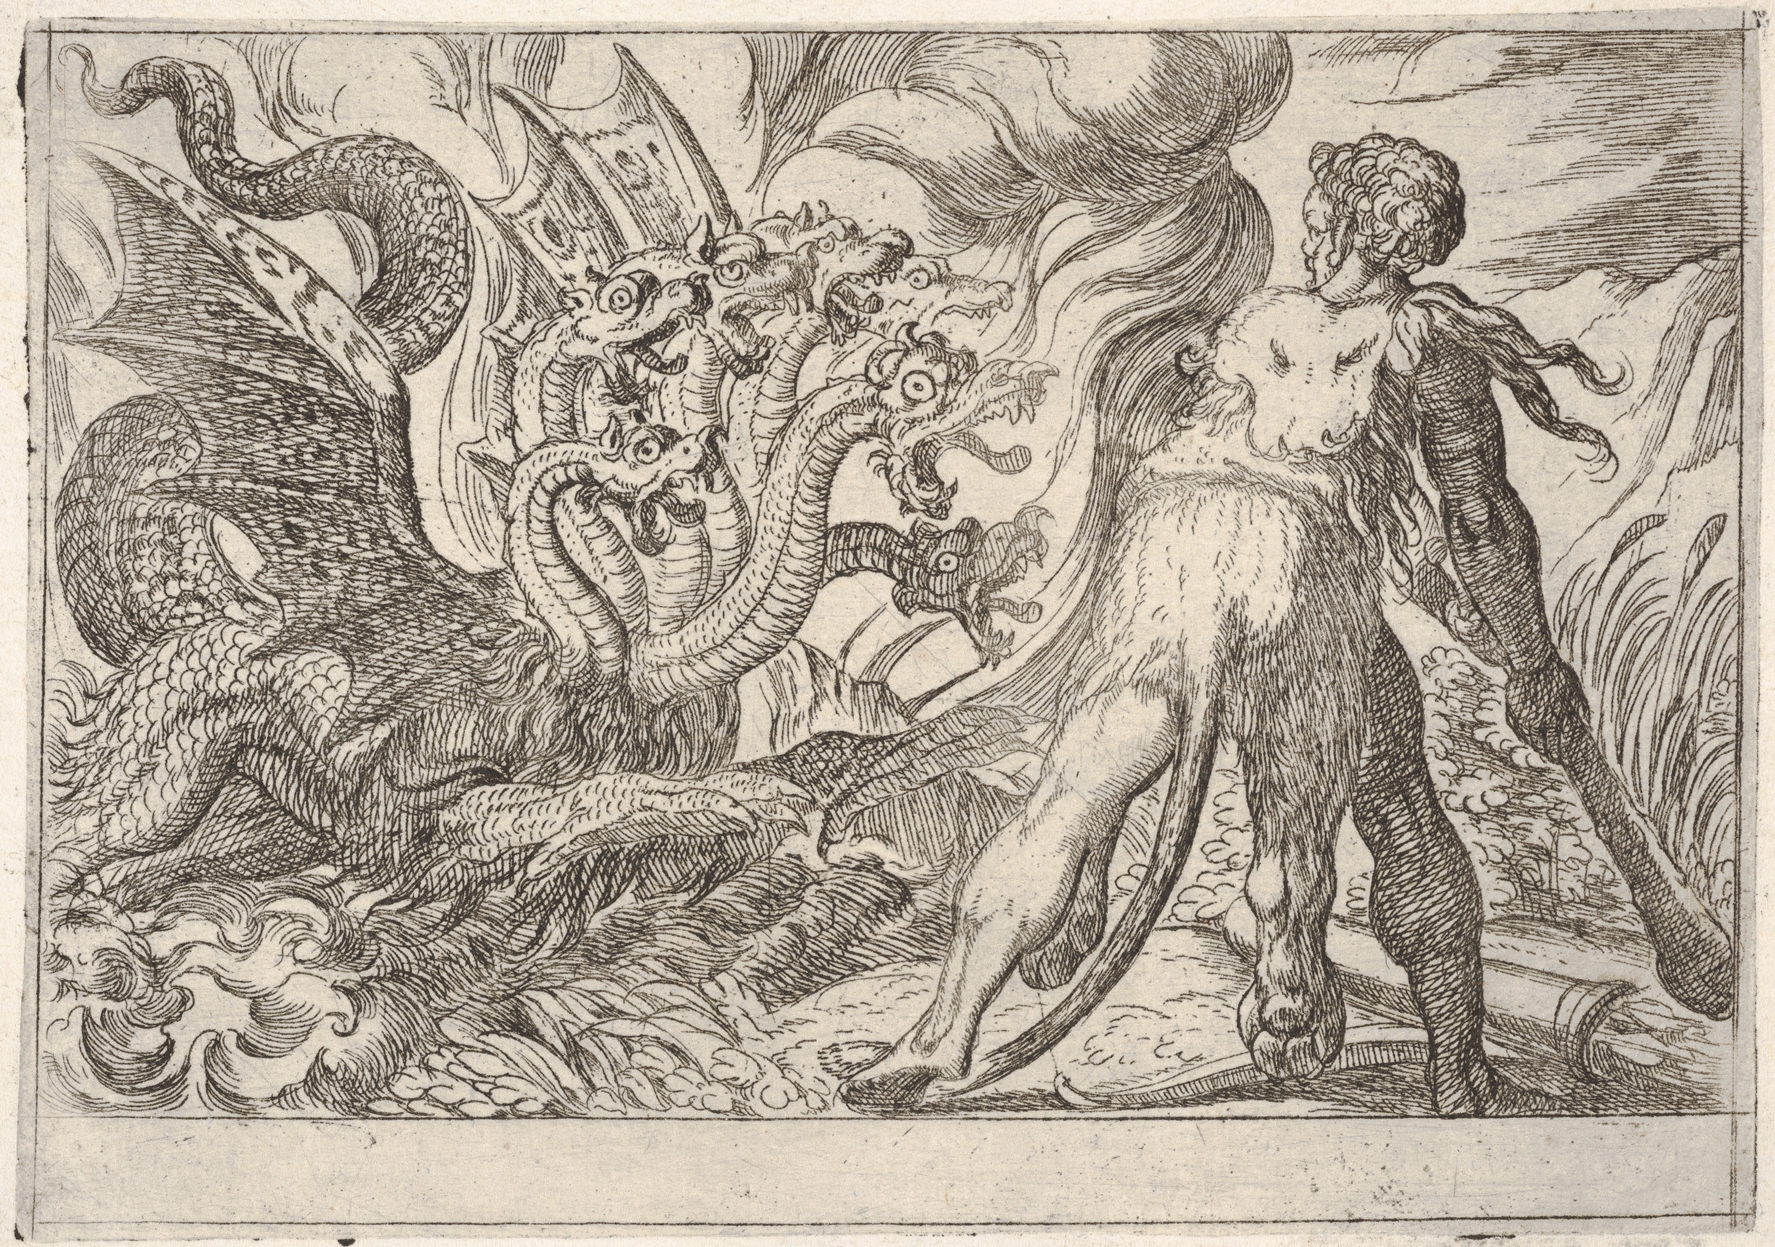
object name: print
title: Hercules and the Hydra of Lerna, from "The Labors of Hercules"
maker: antonio tempesta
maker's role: artist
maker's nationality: italian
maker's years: 1555-1630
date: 1608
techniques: etching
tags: weapons,hercules